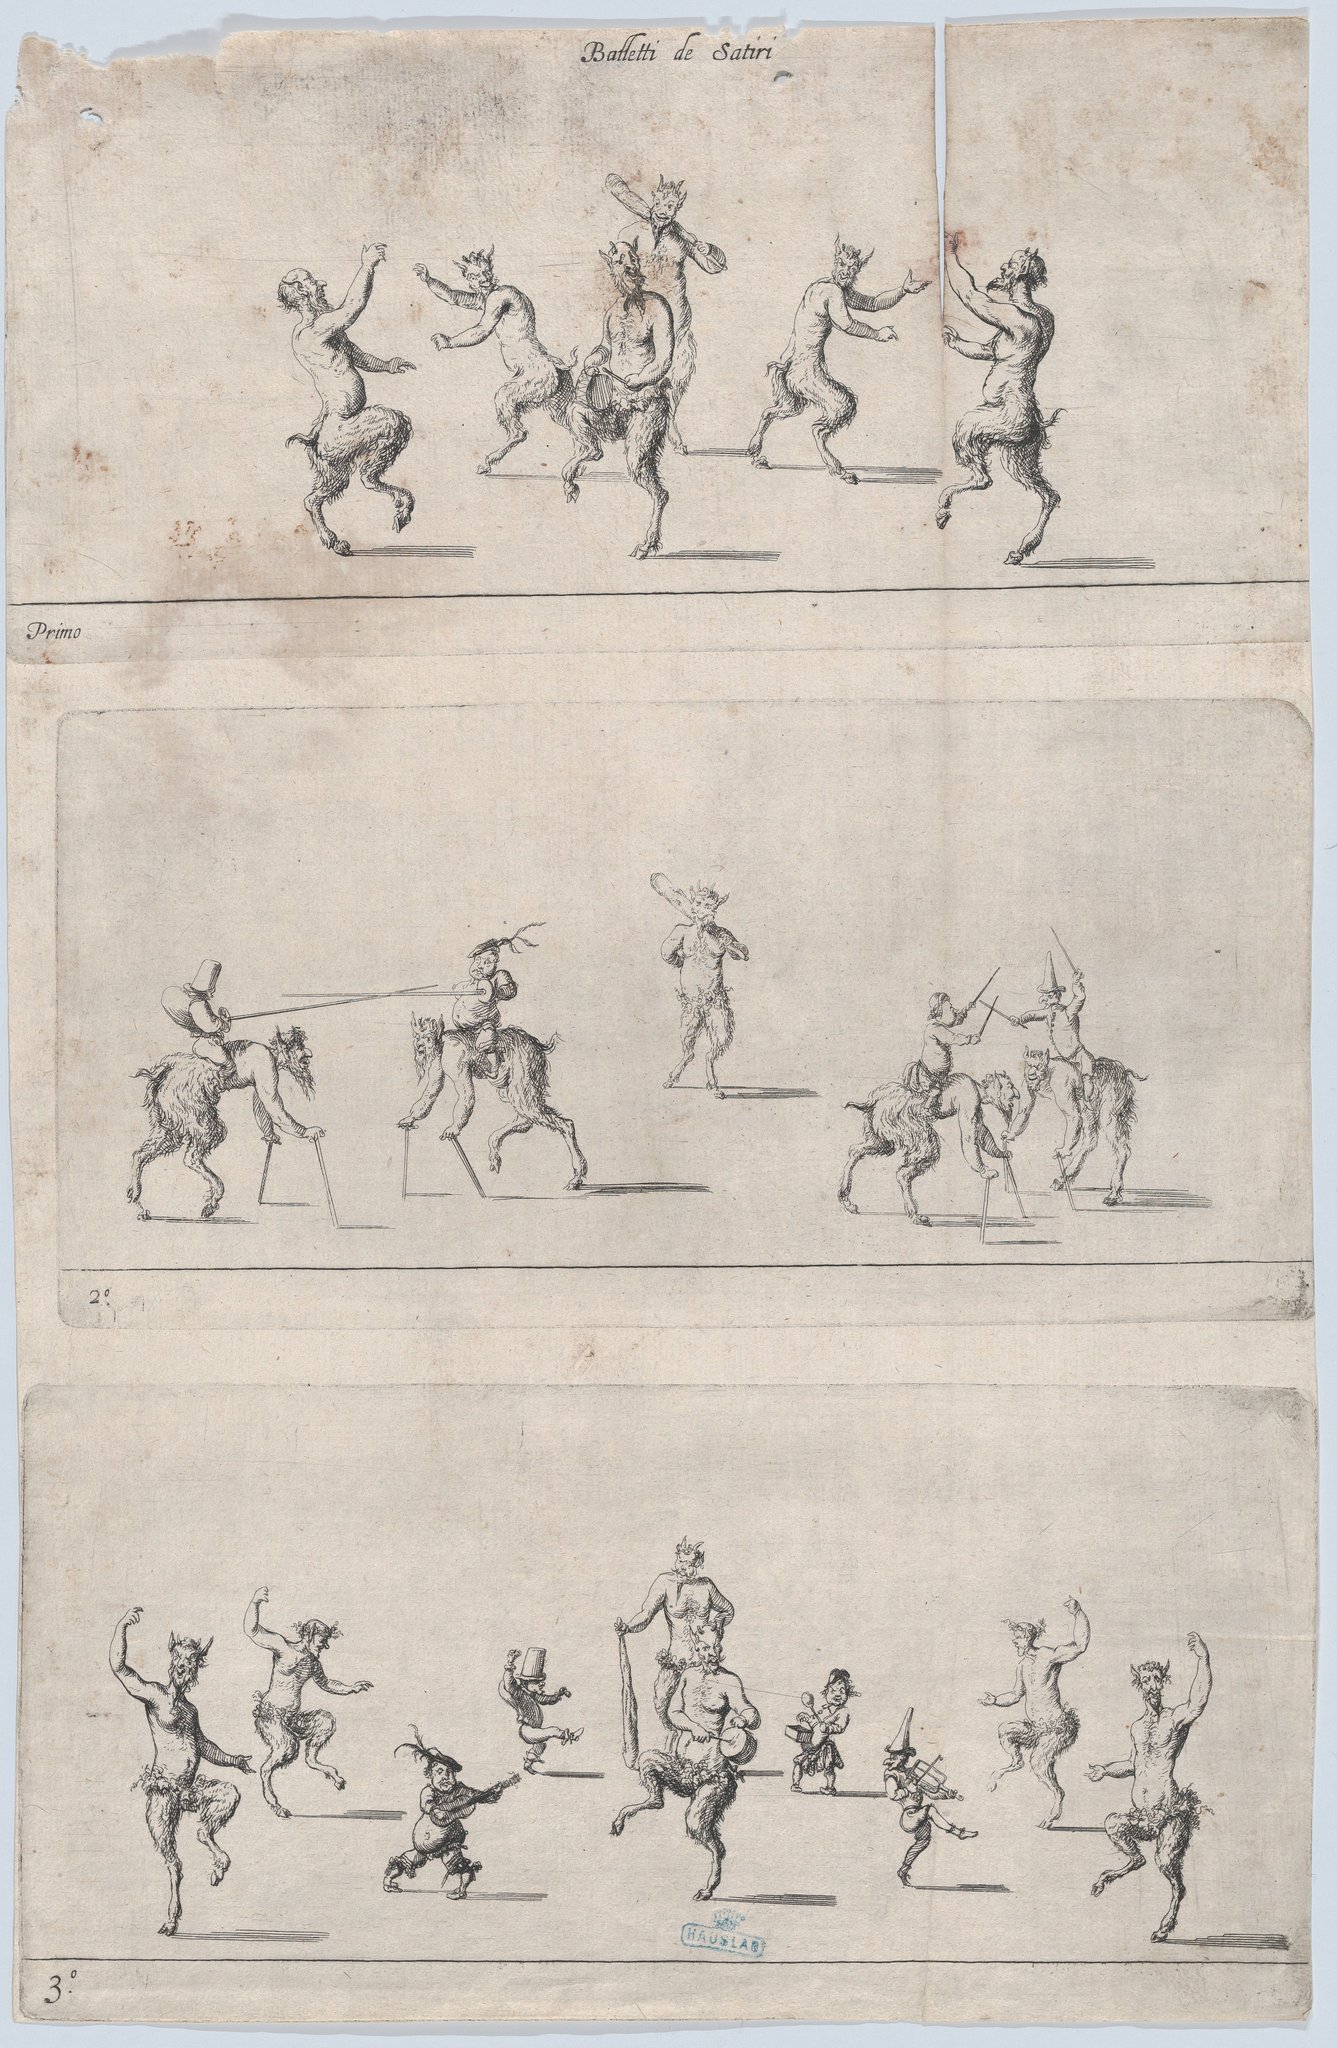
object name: print, fete, ornament architecture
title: Ballets of Satyrs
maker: anonymous, italian, 17th century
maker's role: artist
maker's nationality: italian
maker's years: 1600-1700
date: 1601-1700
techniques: etching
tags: satyrs